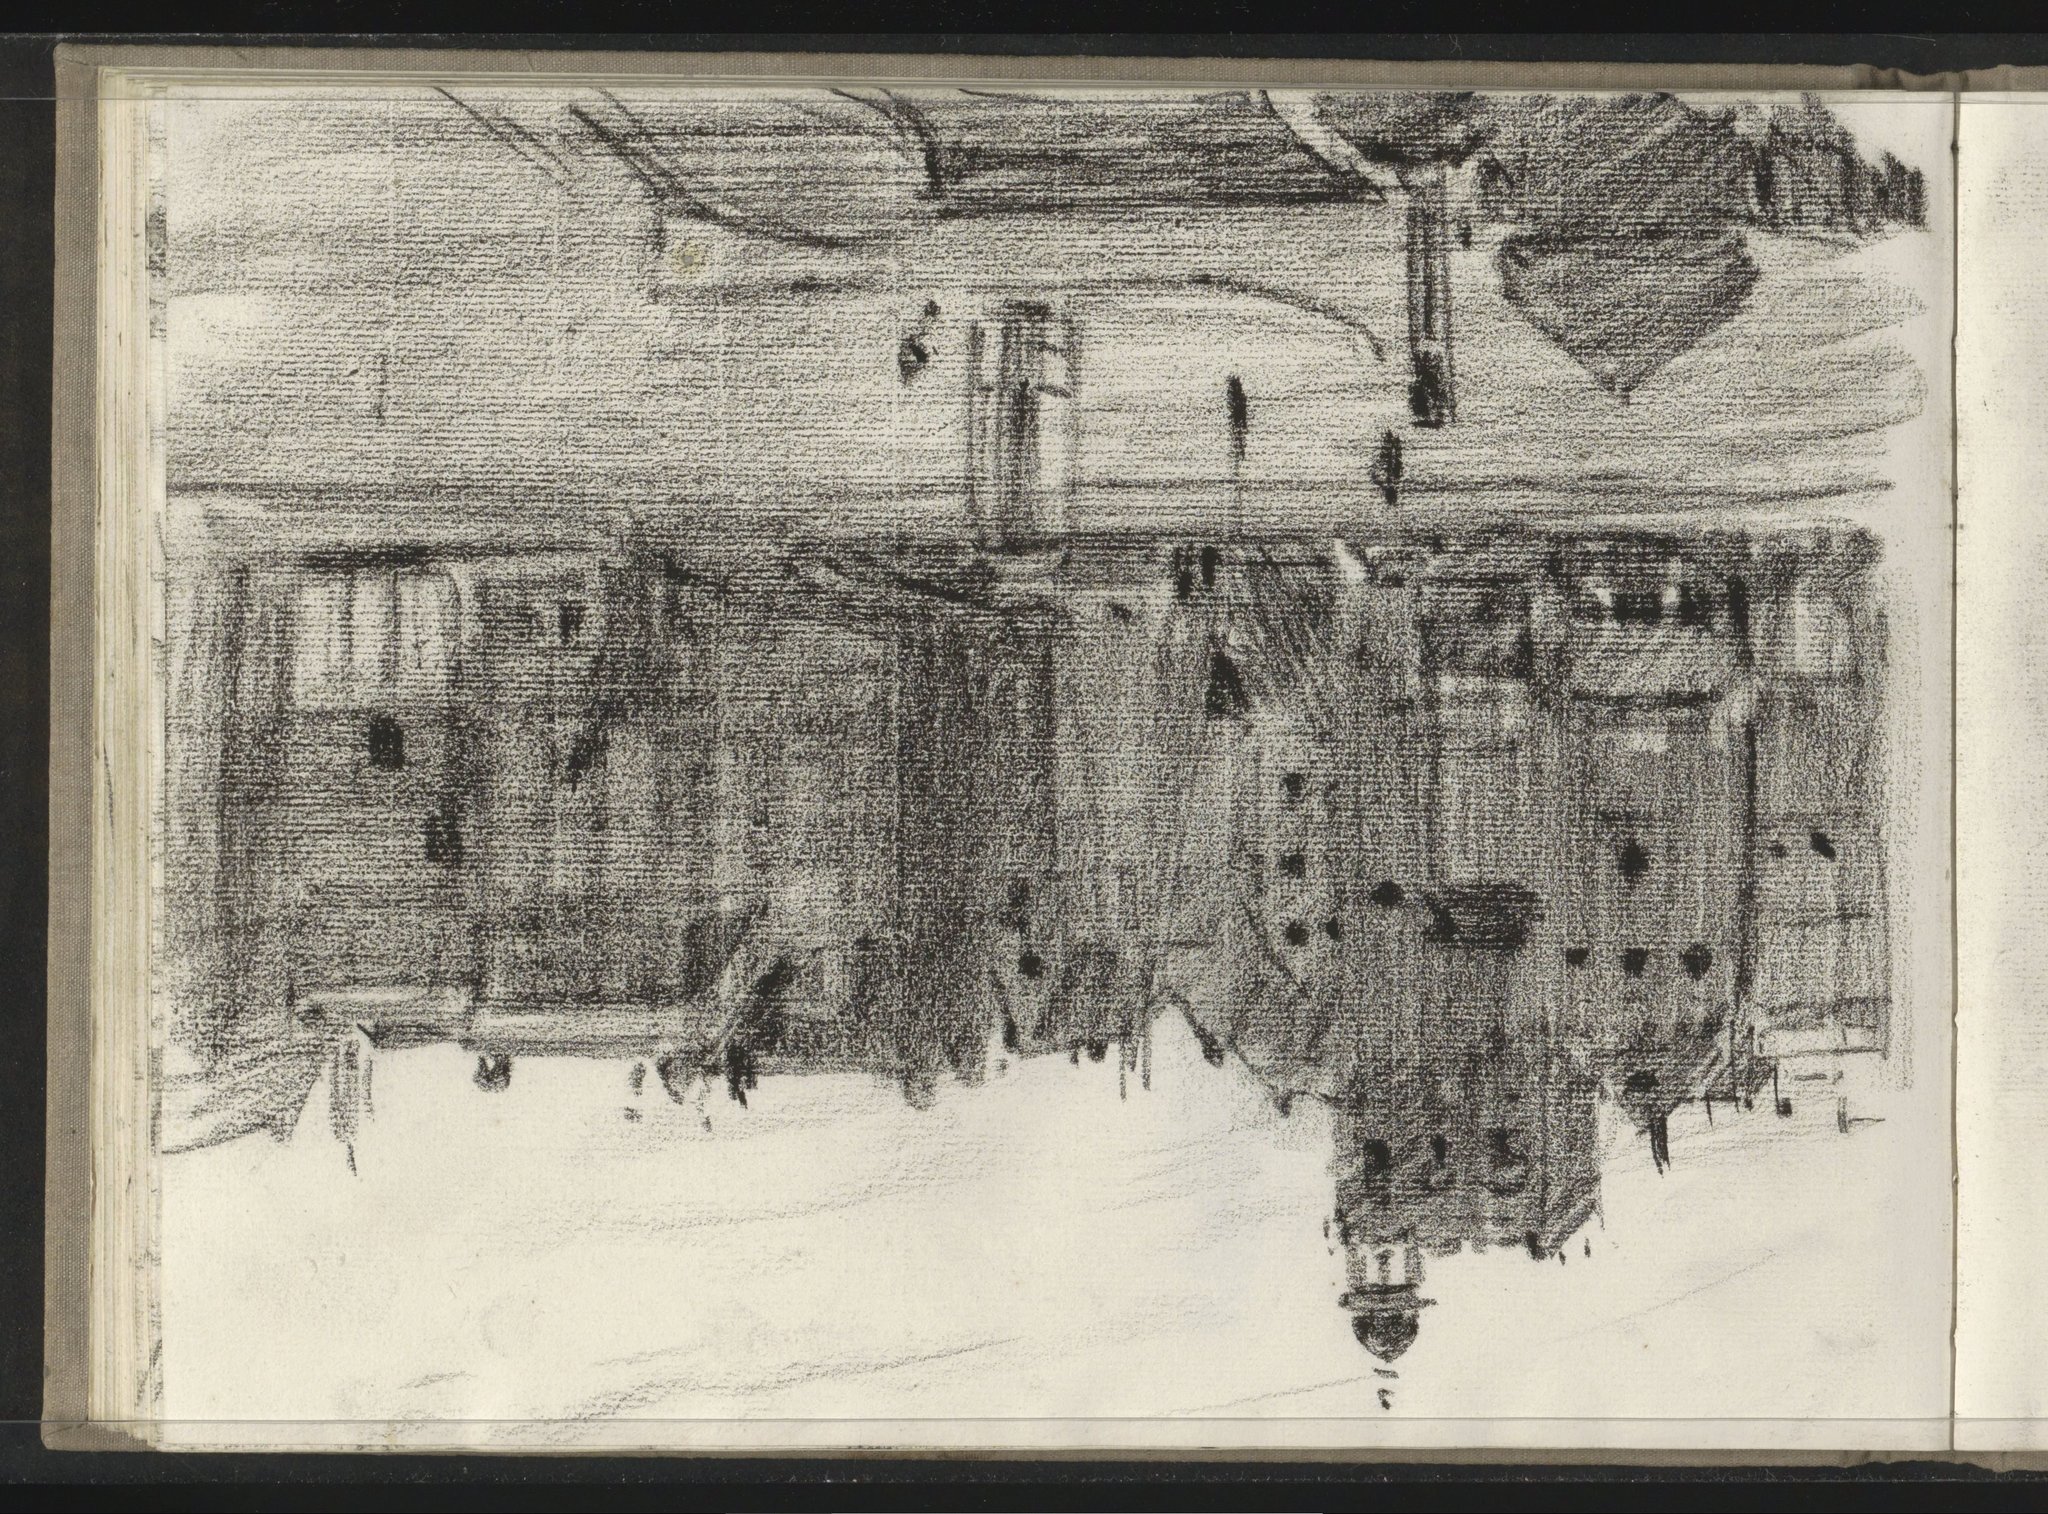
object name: sketchbook leaf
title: Gezicht op het Damrak te Amsterdam met een bouwput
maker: willem witsen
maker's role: draughtsman, painter, print maker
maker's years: 1860-1923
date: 1904-1905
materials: chalk, paper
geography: amsterdam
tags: canals, waters (in city), building-site, civic architecture; edifices; dwellings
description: Pagina 110 uit een schetsboek met 72 bladen.